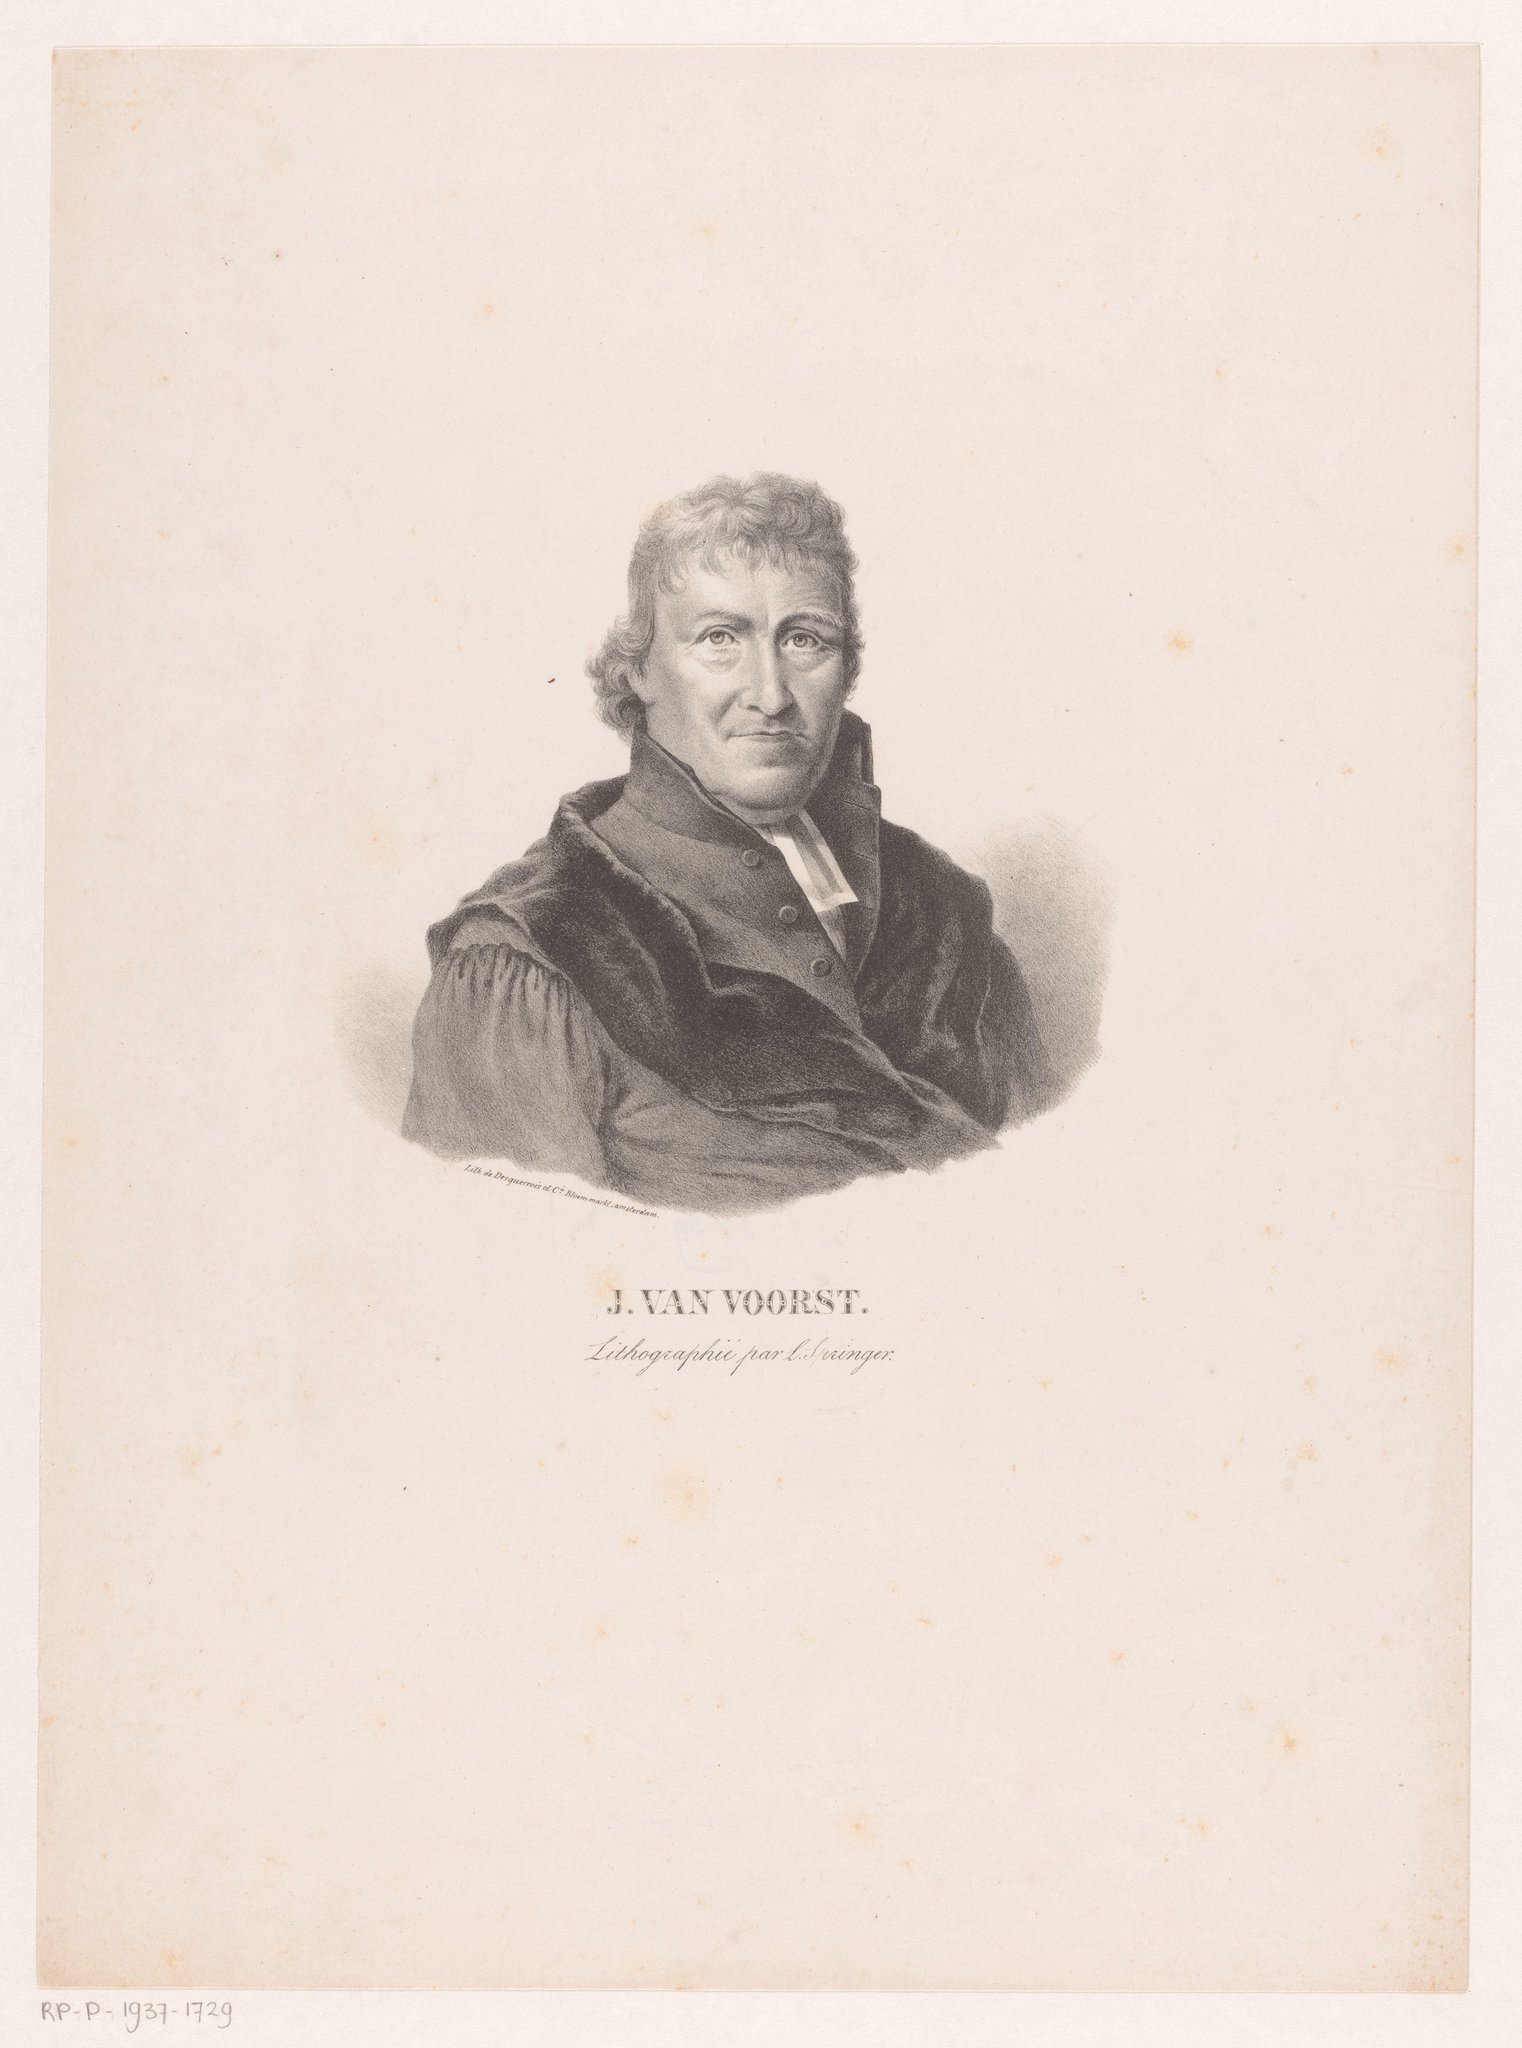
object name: print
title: J. van Voorst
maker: leendert springer (i)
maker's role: draughtsman, painter, print maker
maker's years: 1789-1871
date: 1827-1853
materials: paper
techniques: lithograph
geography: leiden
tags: delft, leiden, historical persons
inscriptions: collector's mark: Lugt 2760, collector's mark: Lugt 2228